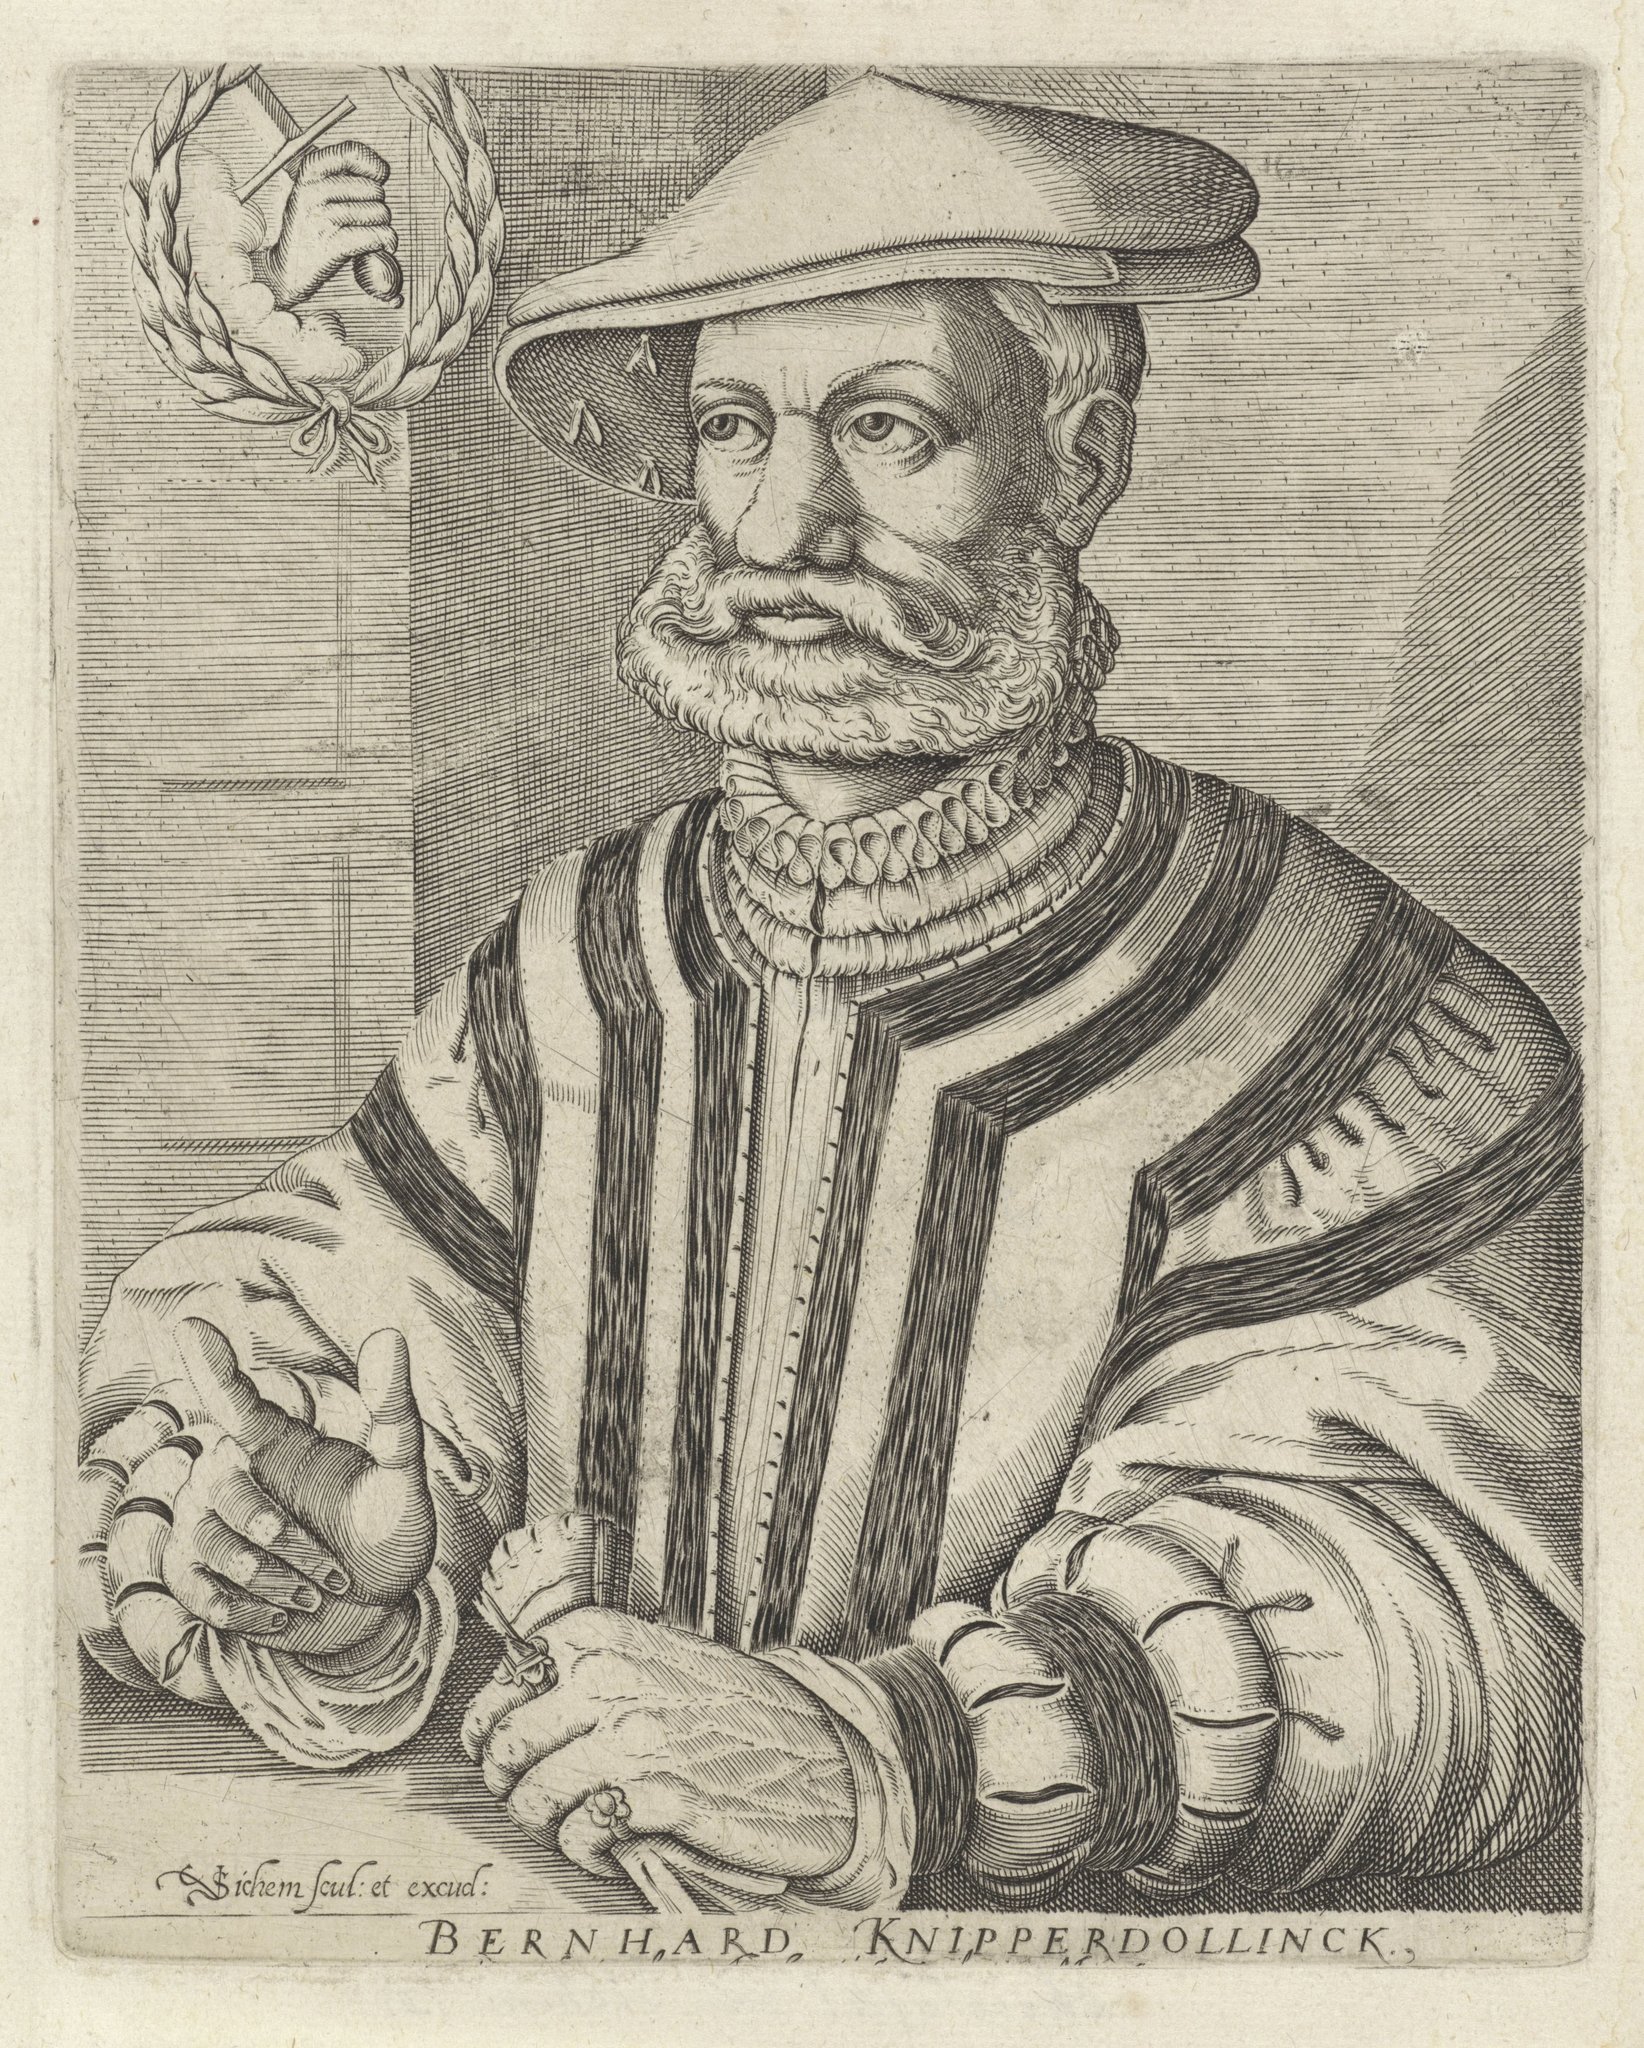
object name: print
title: Portret van Bernardus Knipperdolling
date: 1677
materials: paper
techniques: engraving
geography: middelburg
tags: münster, religieus leider, bernardus knipperdolling, wederdopersoproer in münster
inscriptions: collector's mark: Lugt 2228, collector's mark: Lugt 2760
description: Oorspronkelijk gemaakt voor: 'Historische beschrijvinge ende affbeeldinge der voorneemste hooft ketteren', Amsterdam, C. van Sichem, 1608. Deze prent komt in deze staat voor in: C. van Sichem, 'Het tooneel der hooft-ketteren, bestaande in verscheyde afbeeltsels...', Middelburg, Wilhelmus Goeree, 1677.